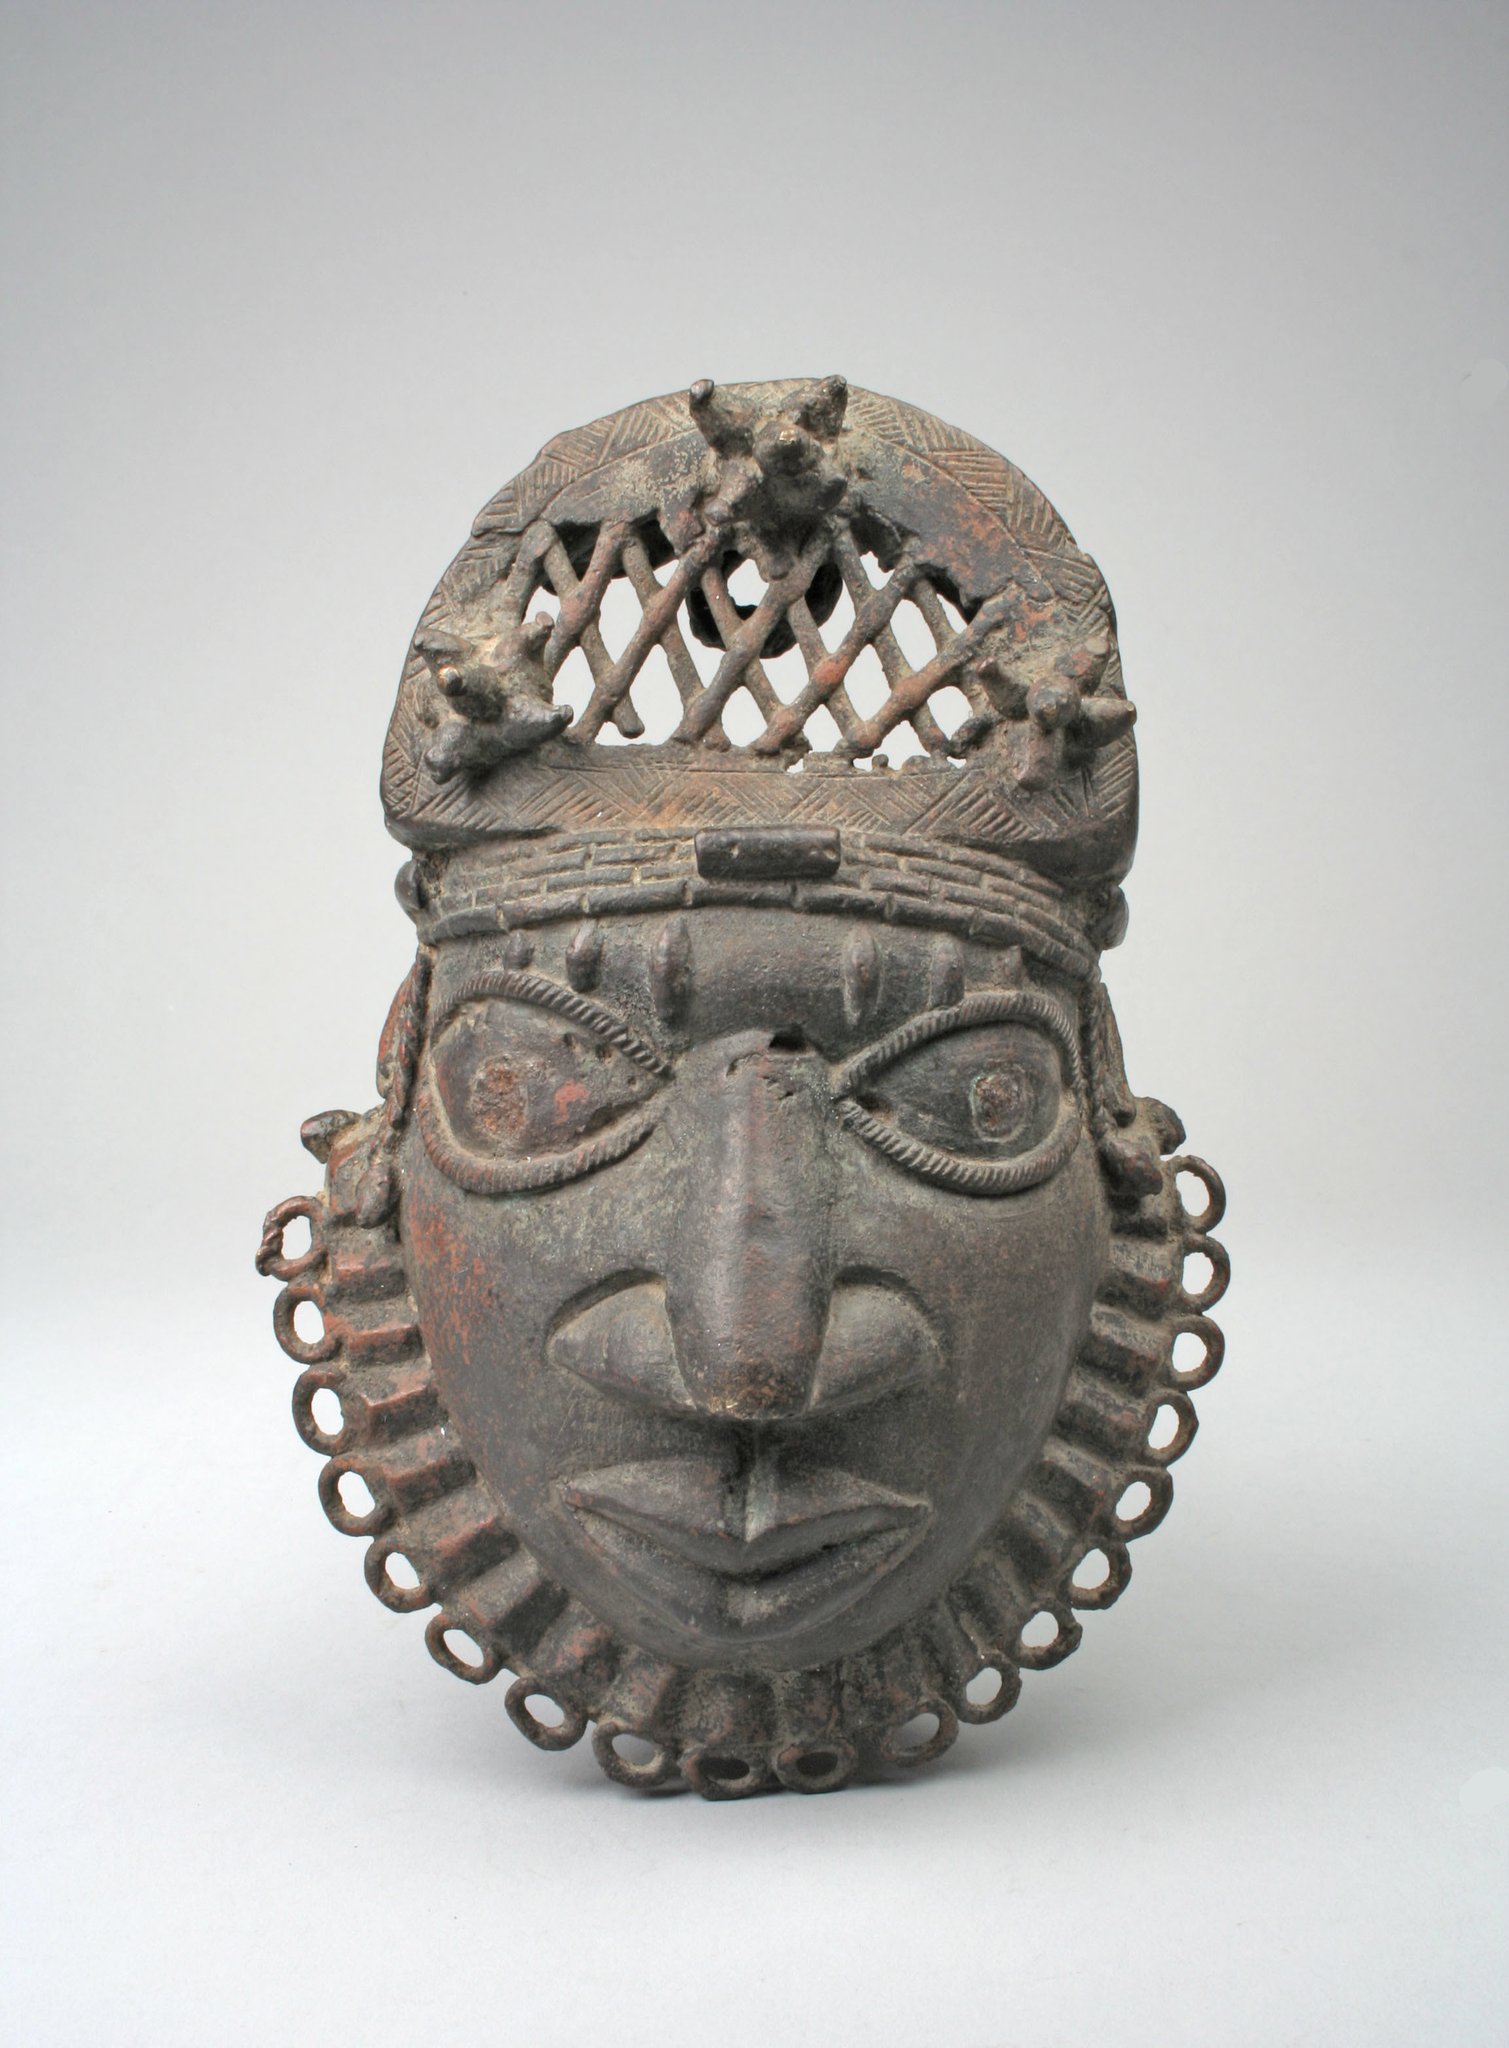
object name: ornament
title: Hip Ornament: Face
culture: edo period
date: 1501-1900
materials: brass, iron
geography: nigeria